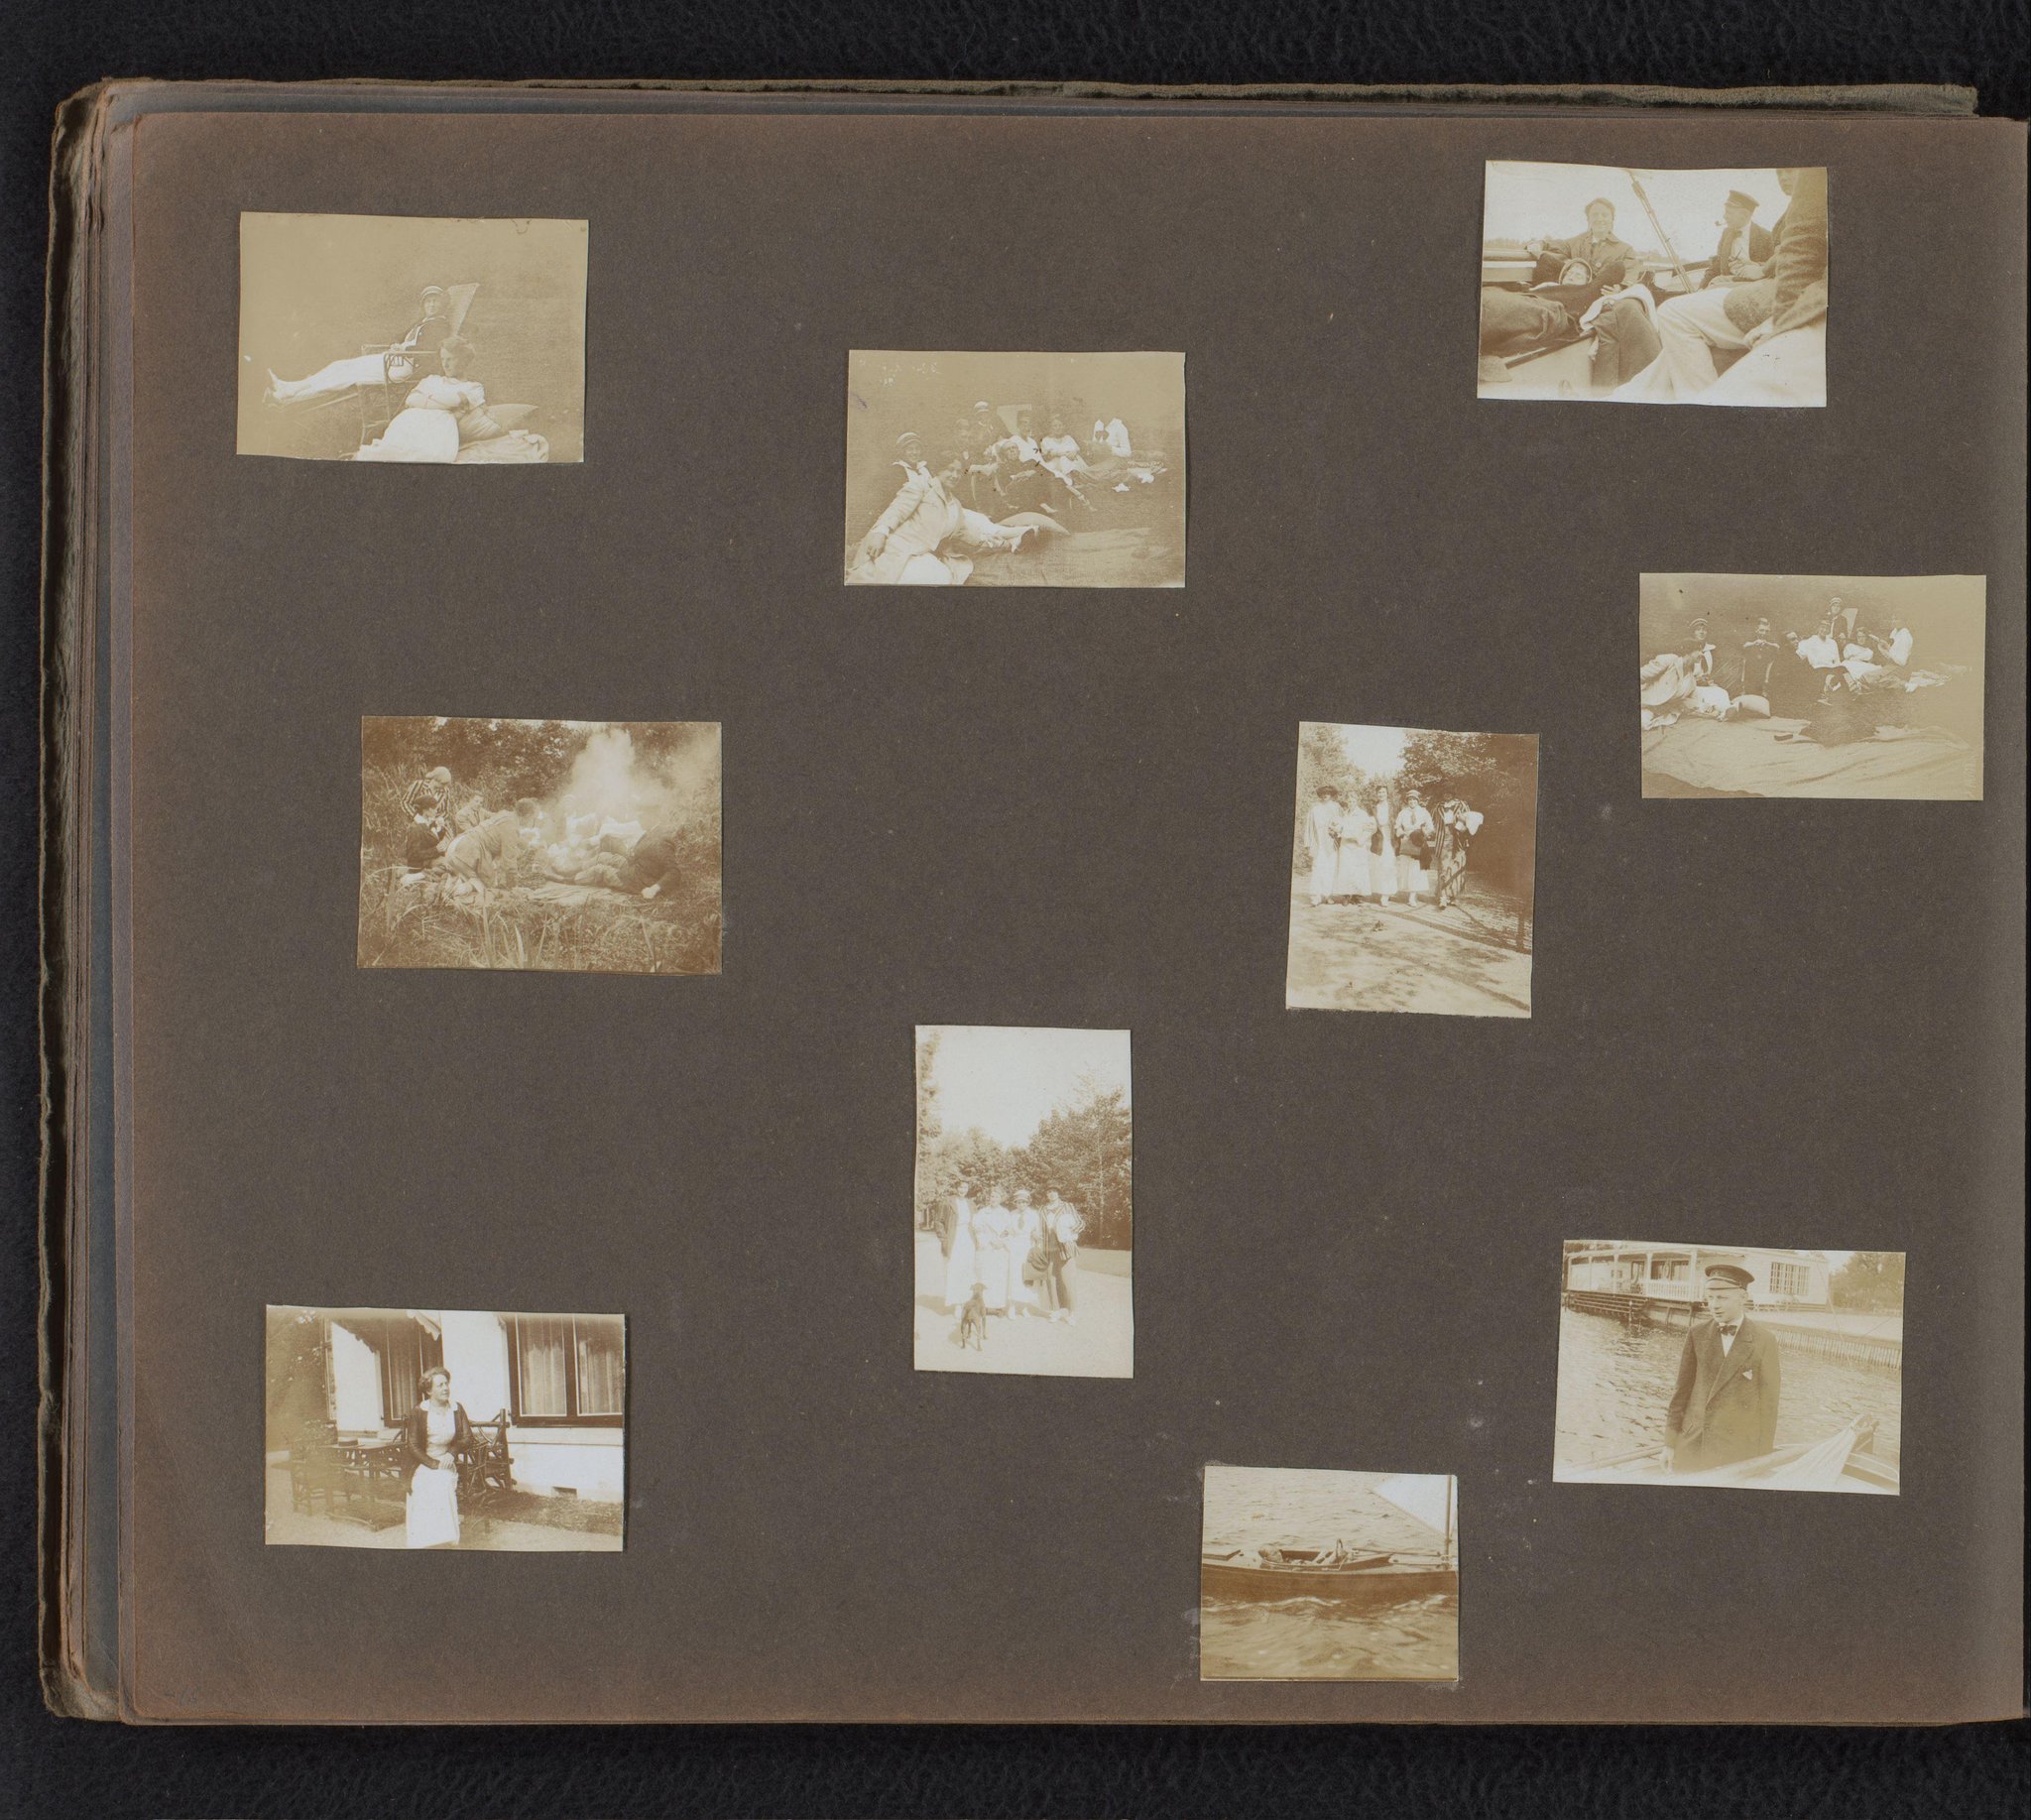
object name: album leaf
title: Vriendengroep tijdens een vaartocht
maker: Anonymous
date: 1913-1914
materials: paper, cardboard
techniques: gelatin silver print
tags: sailing-ship, sailing-boat, friends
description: Deze foto's zijn onderdeel van een album.